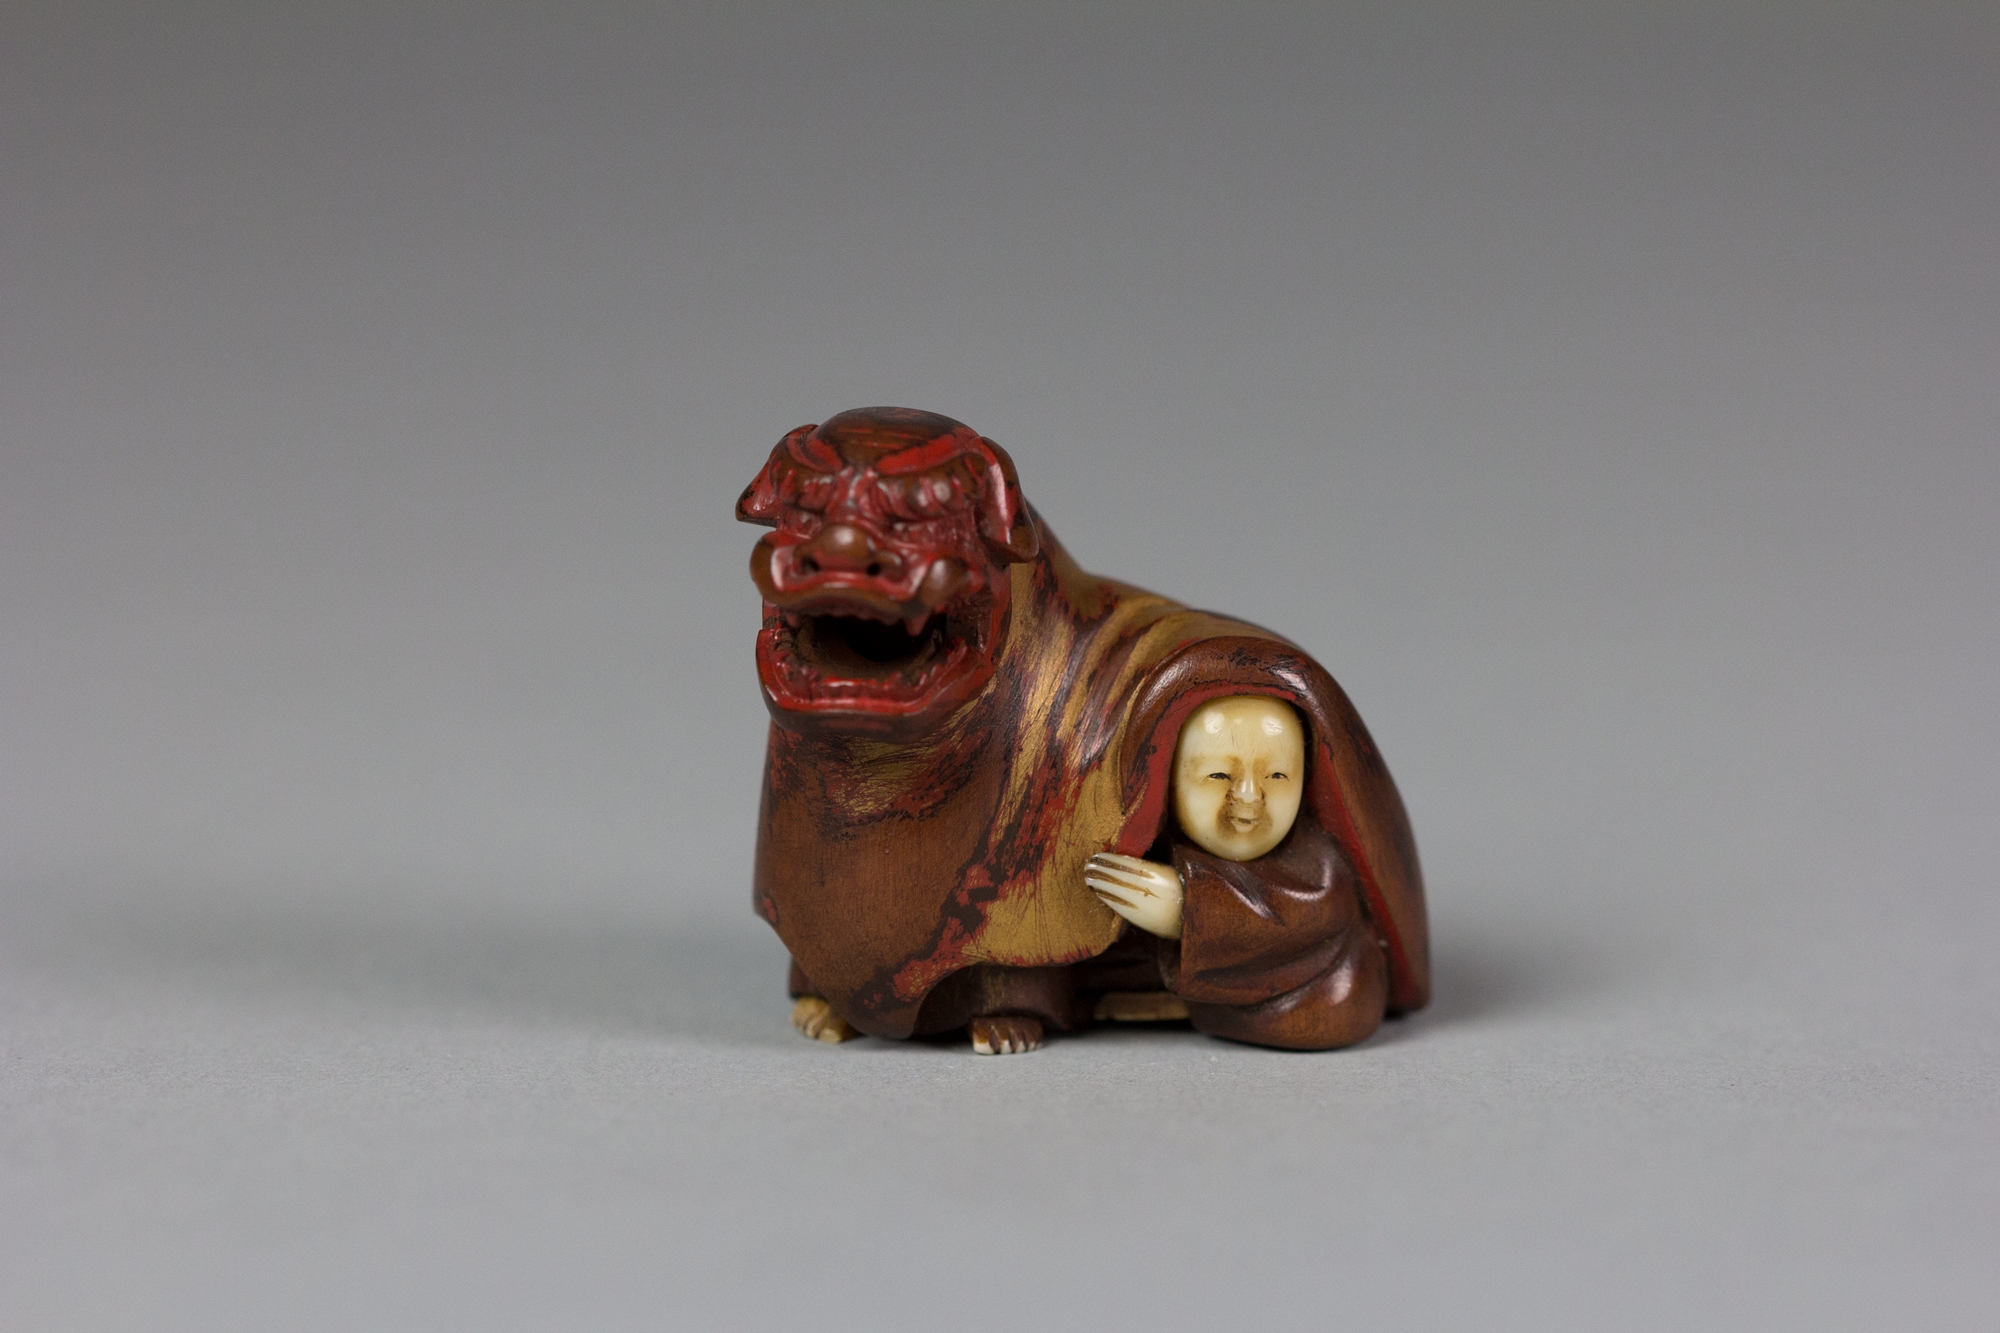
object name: netsuke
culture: japanese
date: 1801-1900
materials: ivory, wood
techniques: inlay, lacquer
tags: human figures,animals